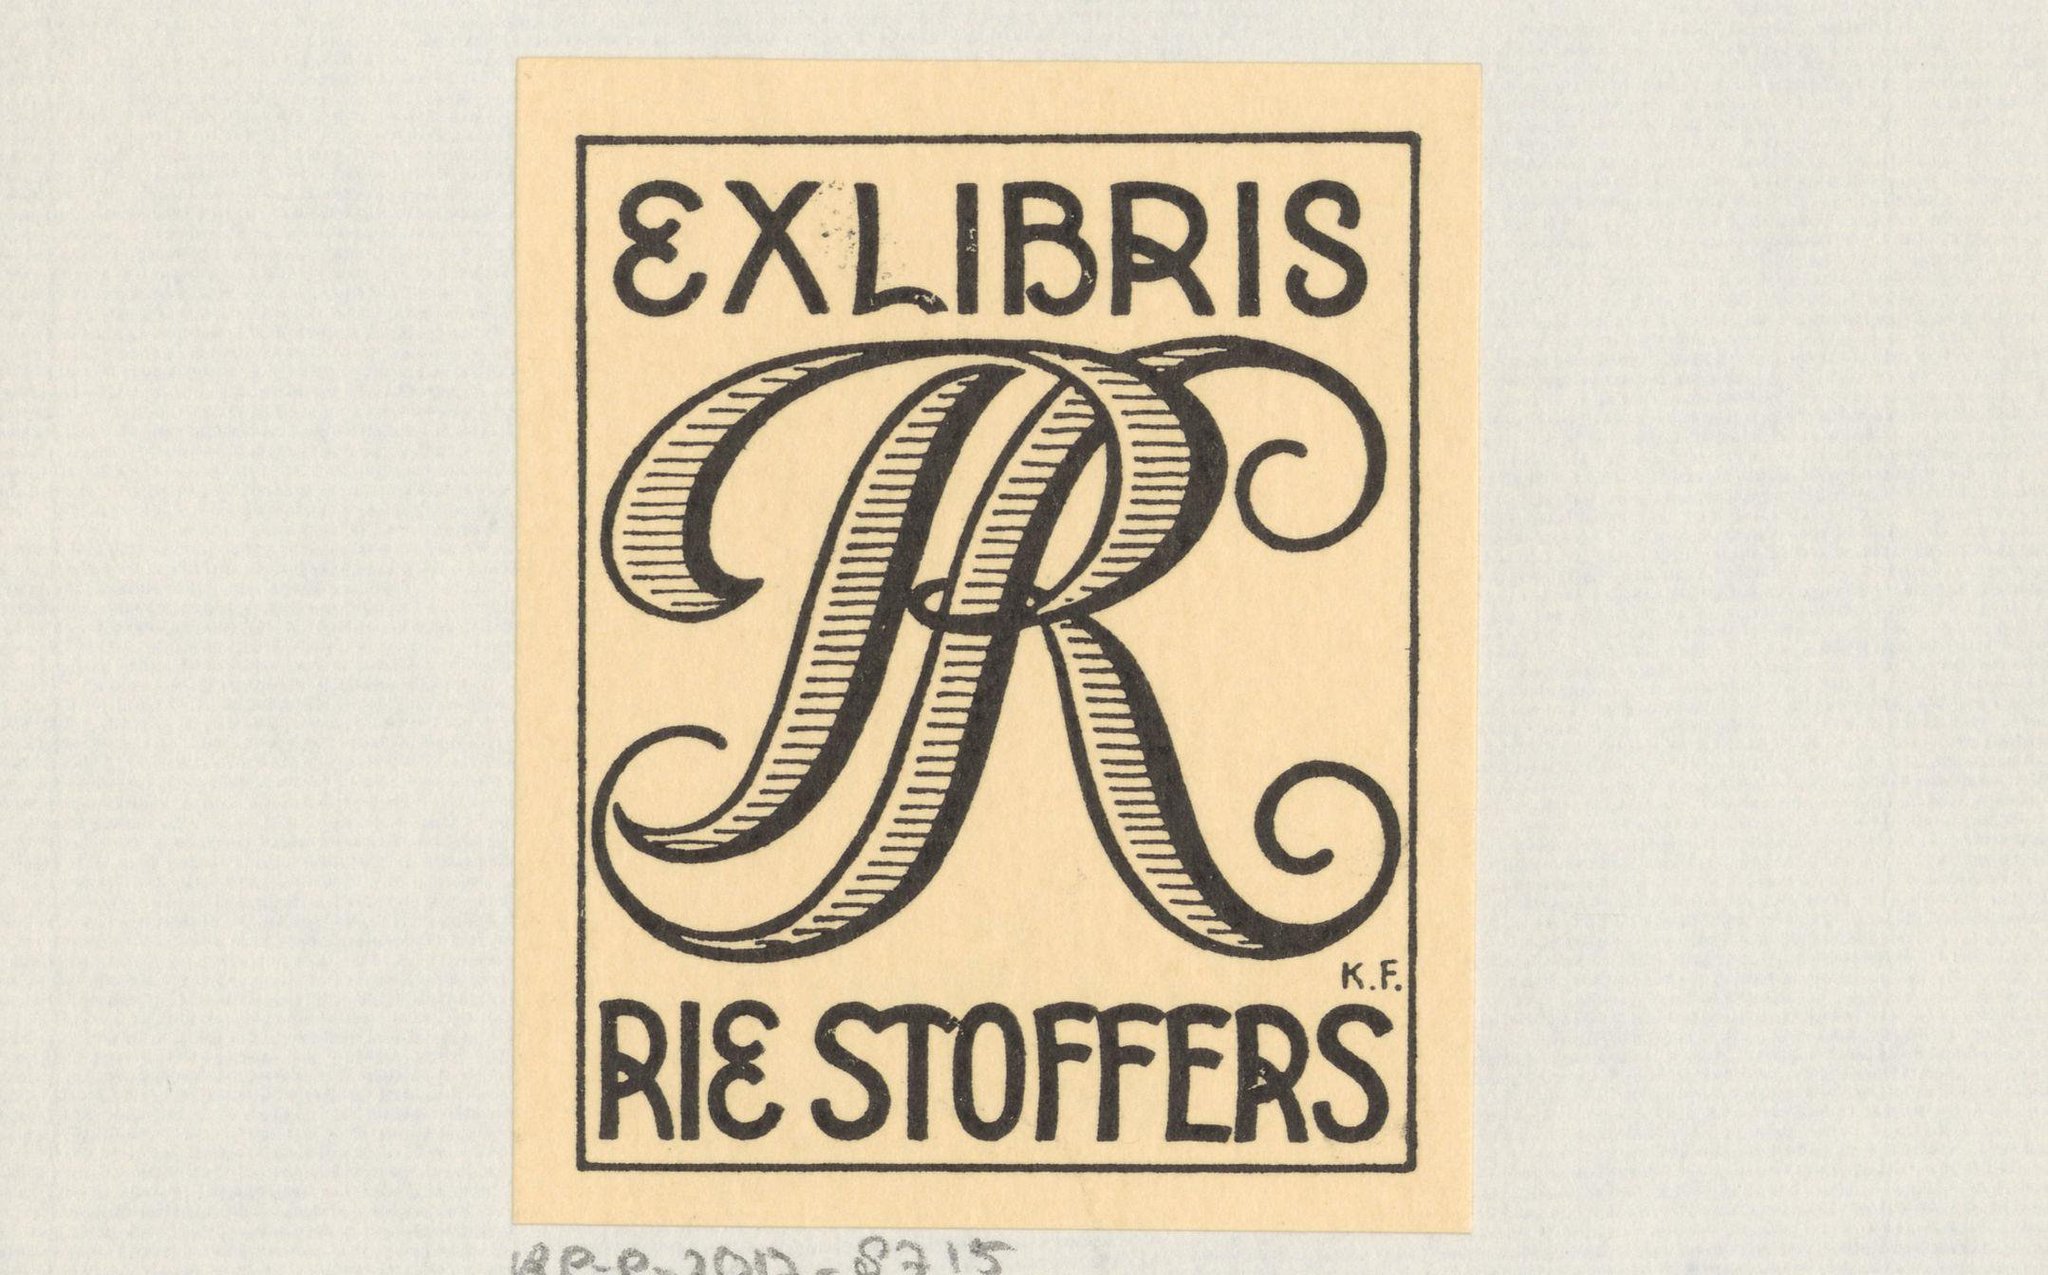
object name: bookplate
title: Ex libris van Rie Stoffers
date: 1937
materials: paper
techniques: printing block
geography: bratislava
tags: auteur, rie stoffers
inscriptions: inscription: ‘Karl Frech/ Bratislava/ 1937’